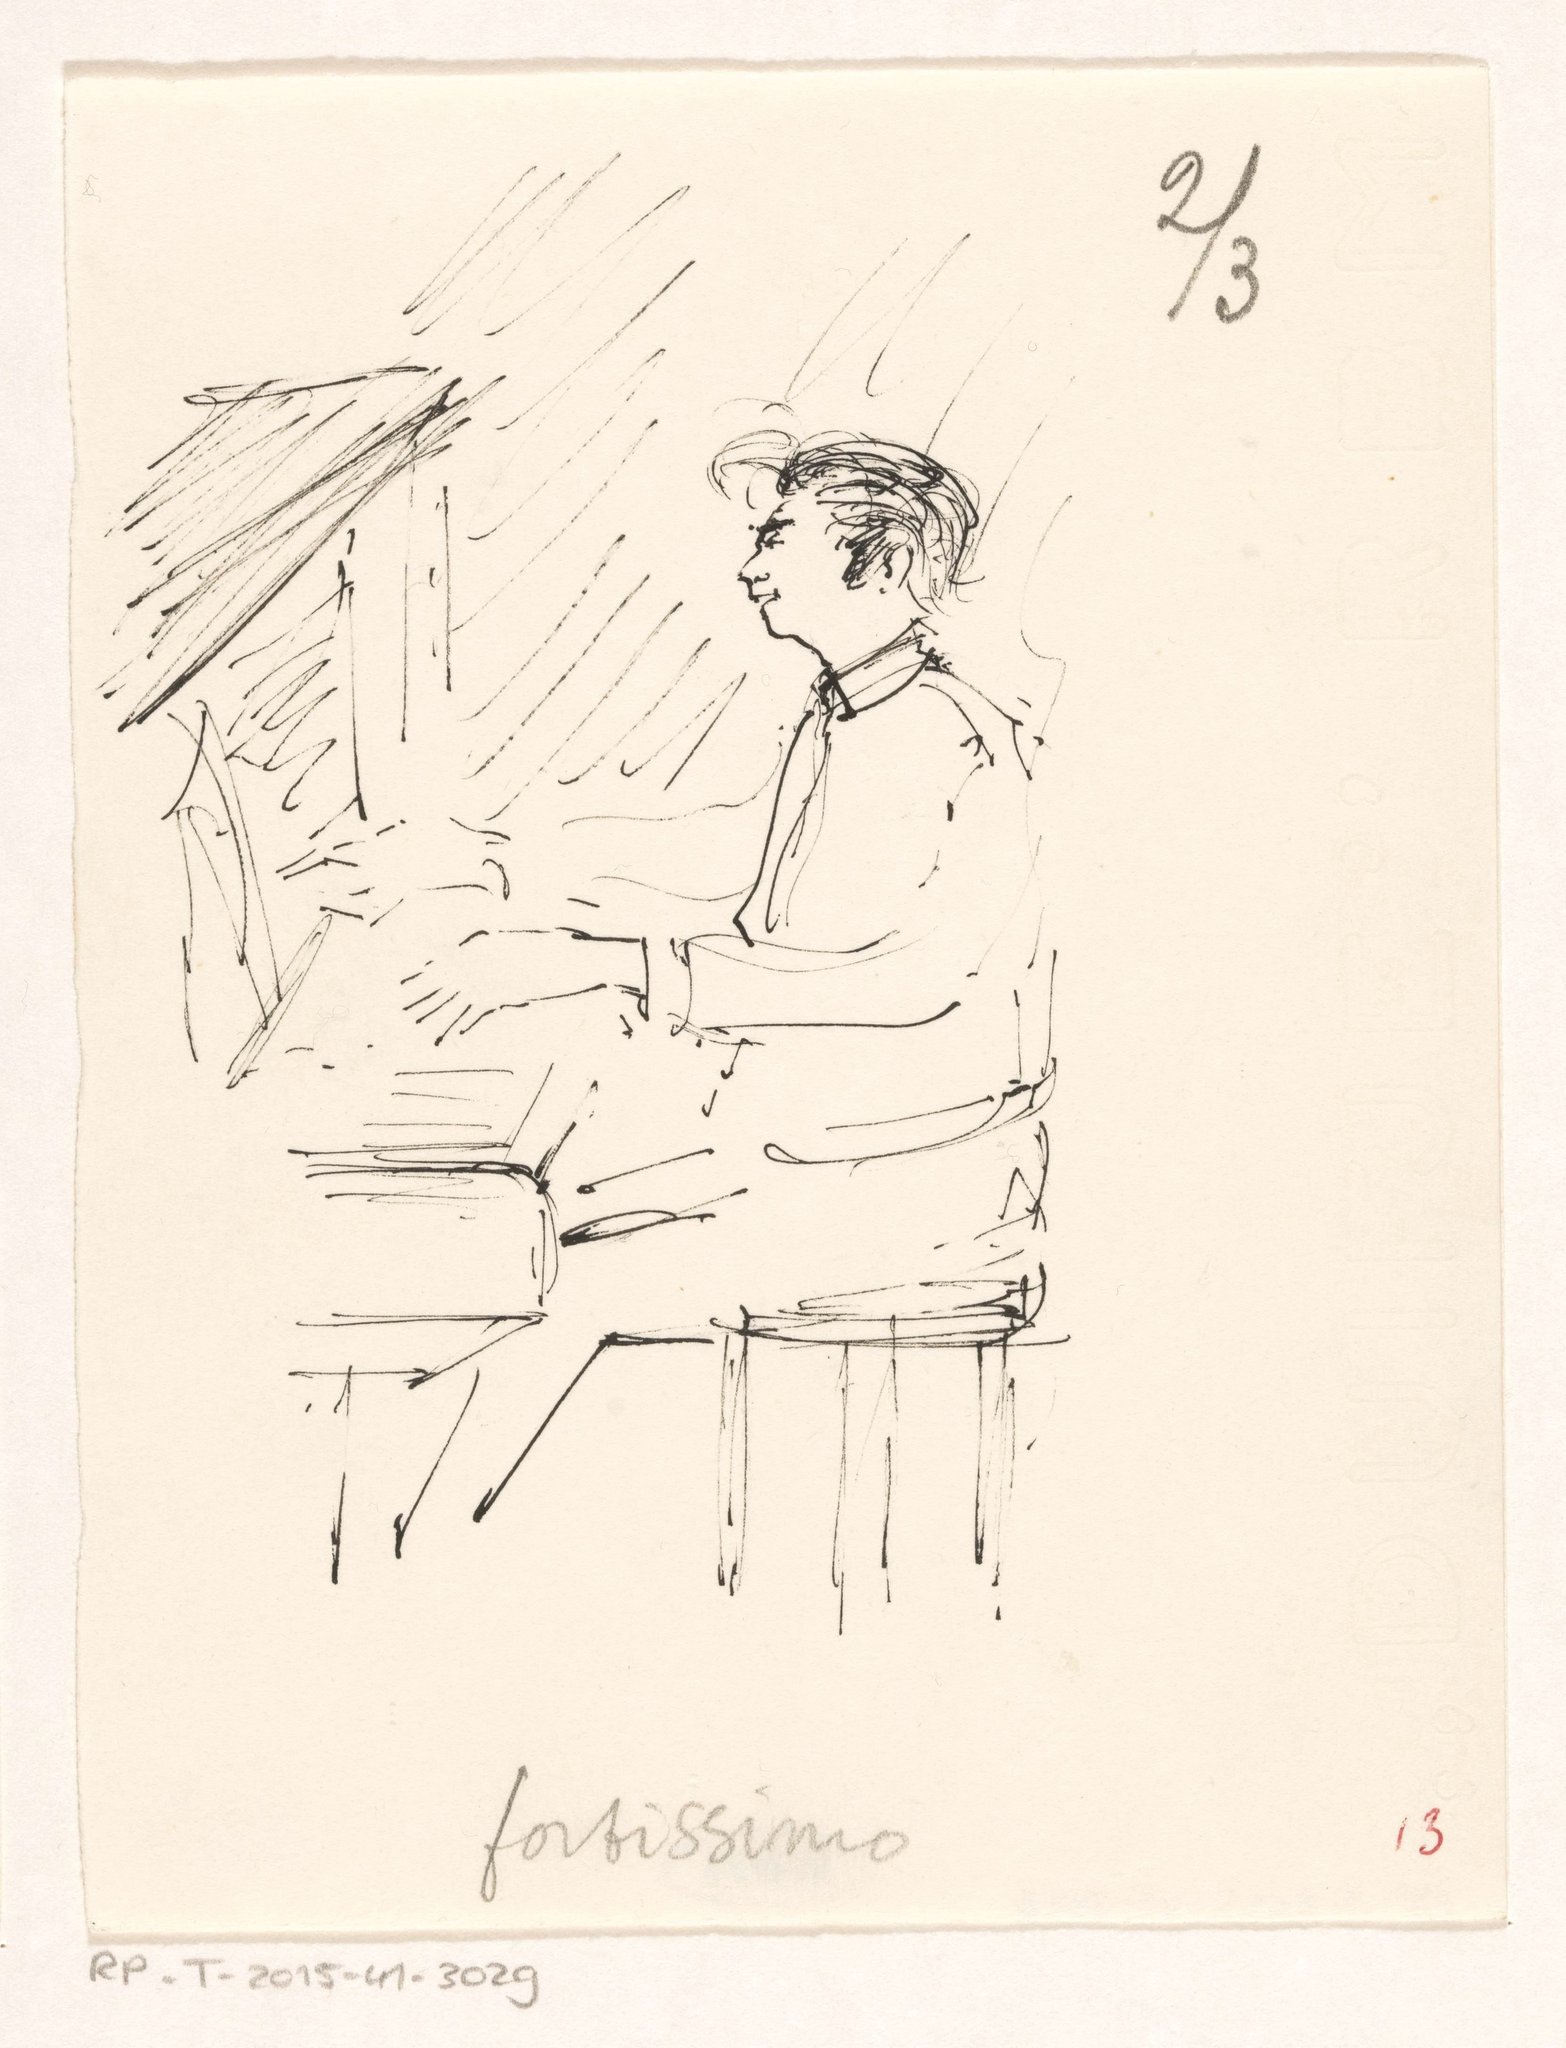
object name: boekillustratie ontwerp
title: Pianospelende man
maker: Anonymous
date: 1930-1970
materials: ink, paper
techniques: pen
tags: pianoforte (+ artist at work)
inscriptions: :, factory mark: ‘"DUIFJE" RBM’, annotation: ‘fortissimo’, collector's mark: Lugt 2228a, number: ‘13’